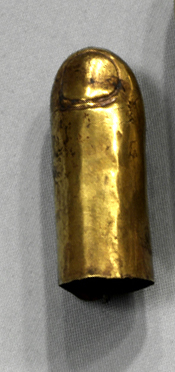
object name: toe stall, group 2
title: Toe stall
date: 1479-1425 BCE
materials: gold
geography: egypt